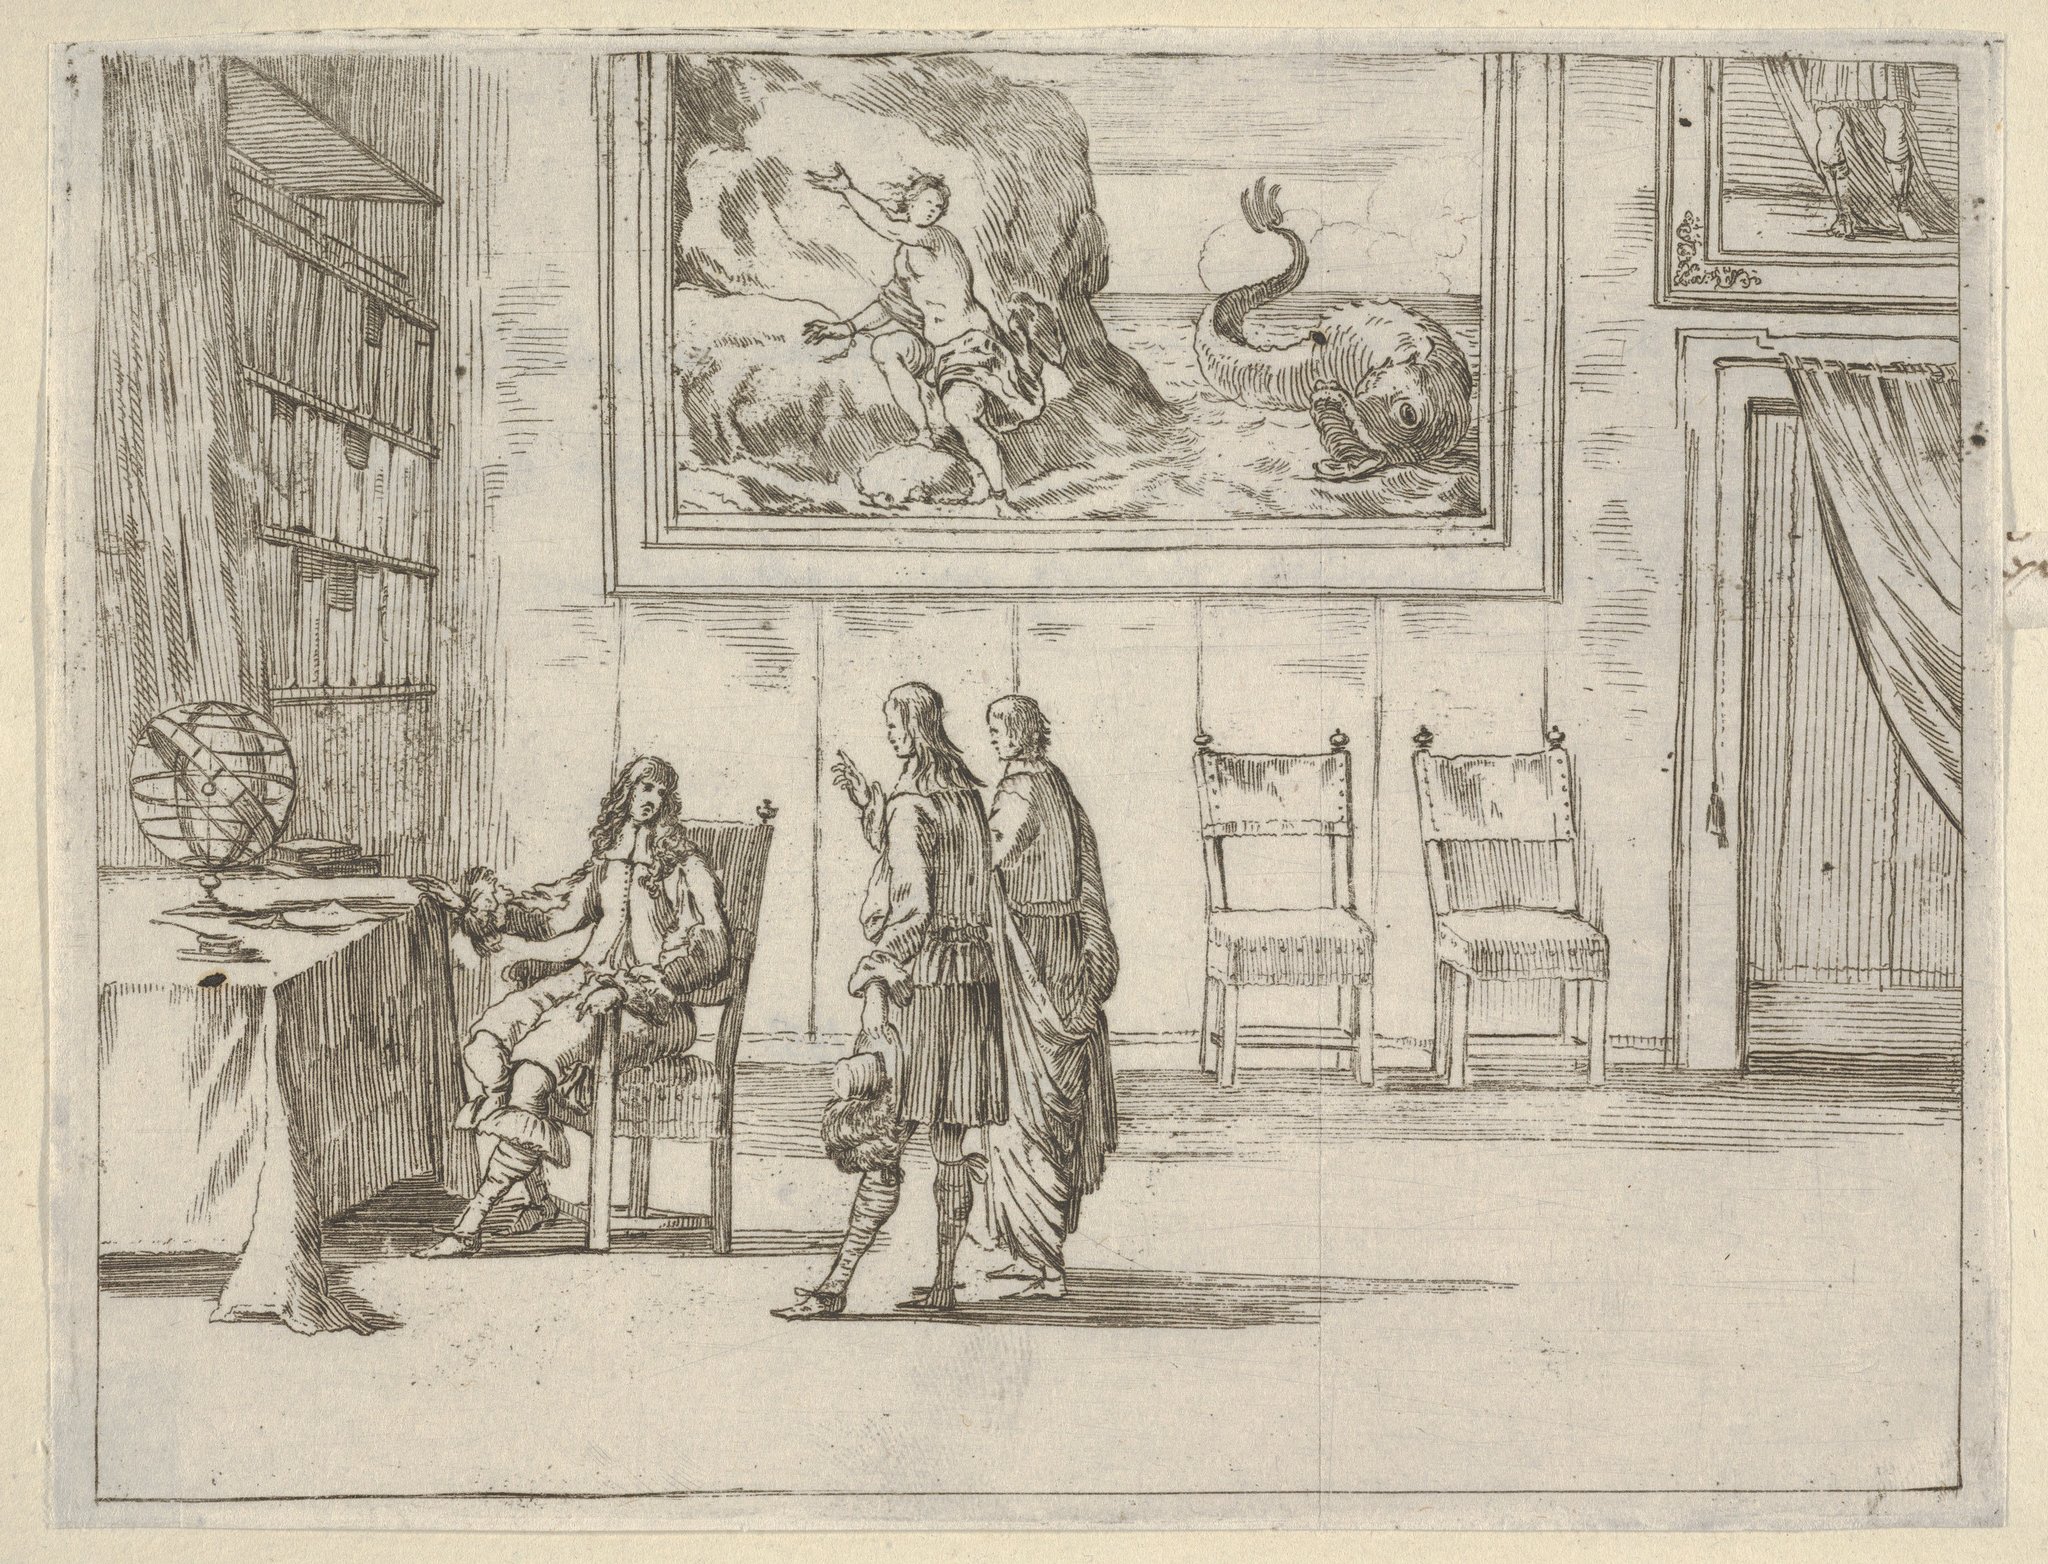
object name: print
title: Francesco I d'Este Displays Great Faculty in his Studies, from "L'Idea di un Principe ed Eroe Cristiano in Francesco I d'Este, di Modena e Reggio Duca VIII [...]"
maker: bartolomeo fenice (fénis)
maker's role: artist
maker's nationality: italian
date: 1659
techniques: etching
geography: italy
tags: men,fish,chairs,globes